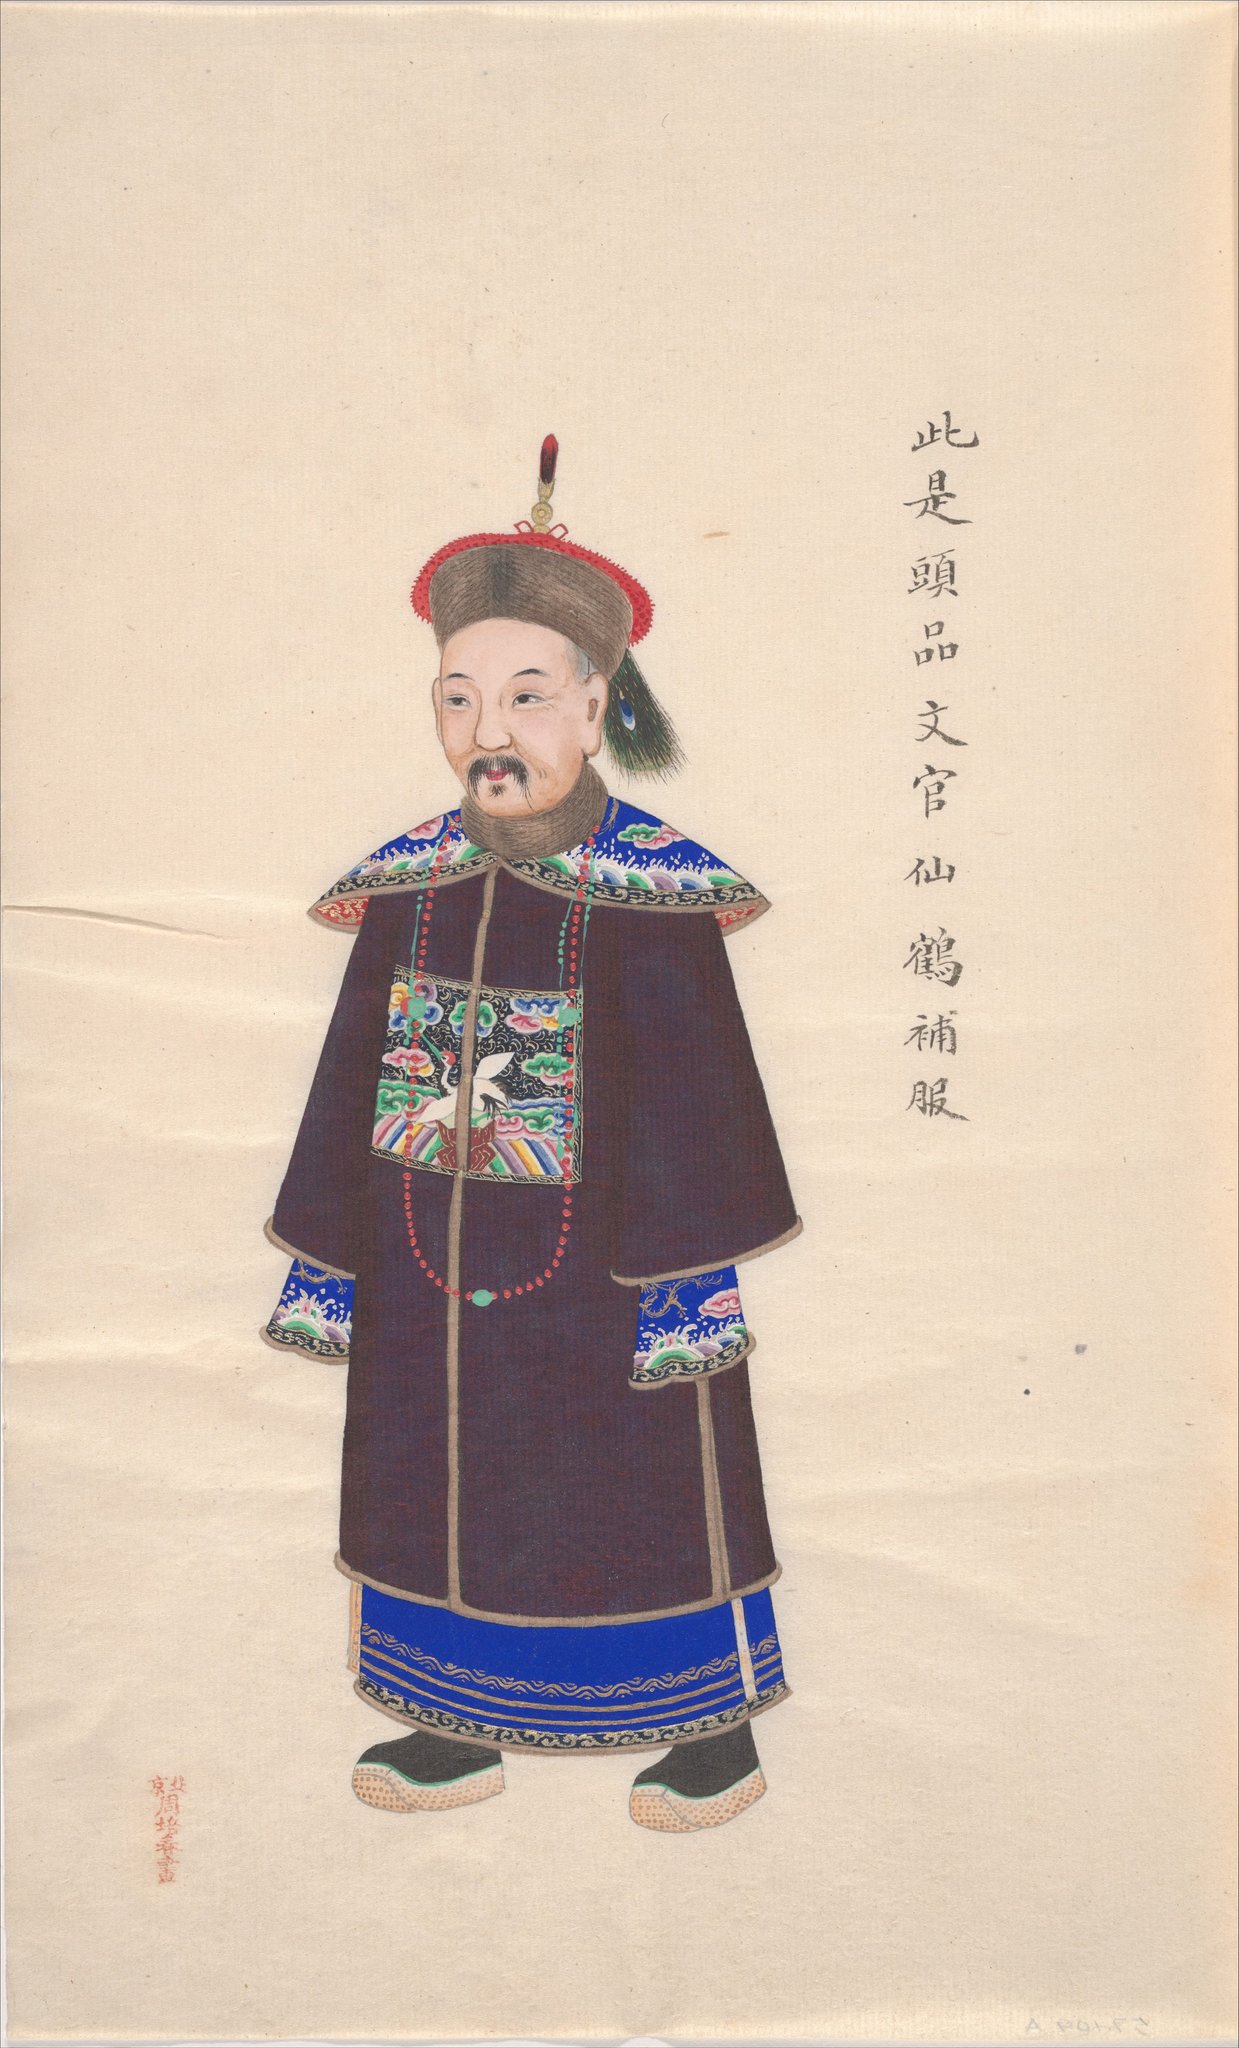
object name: painting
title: Collection of Paintings showing Military Officials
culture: chinese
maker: unidentified artist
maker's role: artist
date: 1644-1911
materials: paper, watercolor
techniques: painting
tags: men